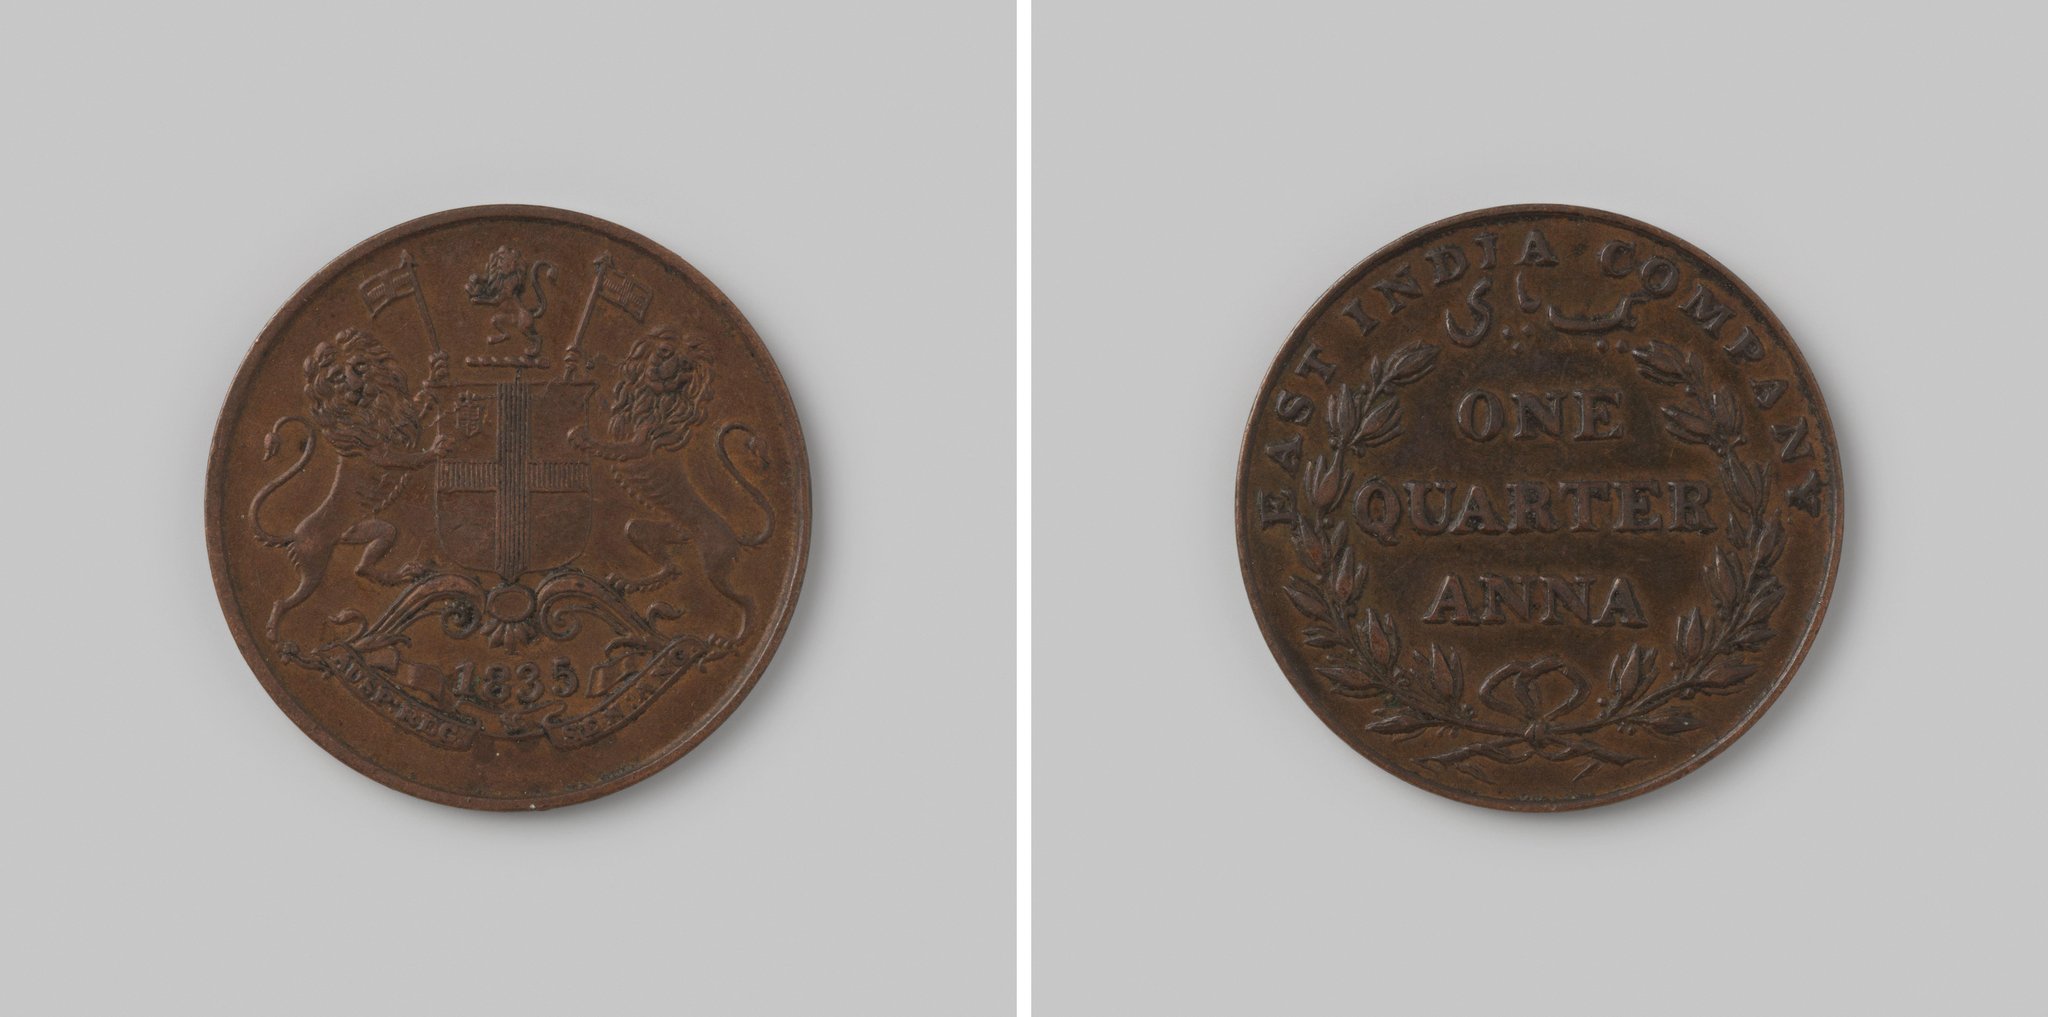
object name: coin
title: Engelse Oostindische Compagnie (EIC), India, 1/4 anna, 1835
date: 1835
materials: copper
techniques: striking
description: Koperen munt. Voorzijde: door twee op banderol, waarin opschrift, staande leeuwen met pijl, waaraan vlag, in de klauw, gehouden wapenschild van de EIC, waarboven helmteken. Tussen wapenschild en banderol jaartal. Keerzijde: tussen twee samengebonden takken in drie regels waarde-aanduiding: one quarter anna, waarboven waarde-aanduiding in Arabische lettertekens. Gladde rand.